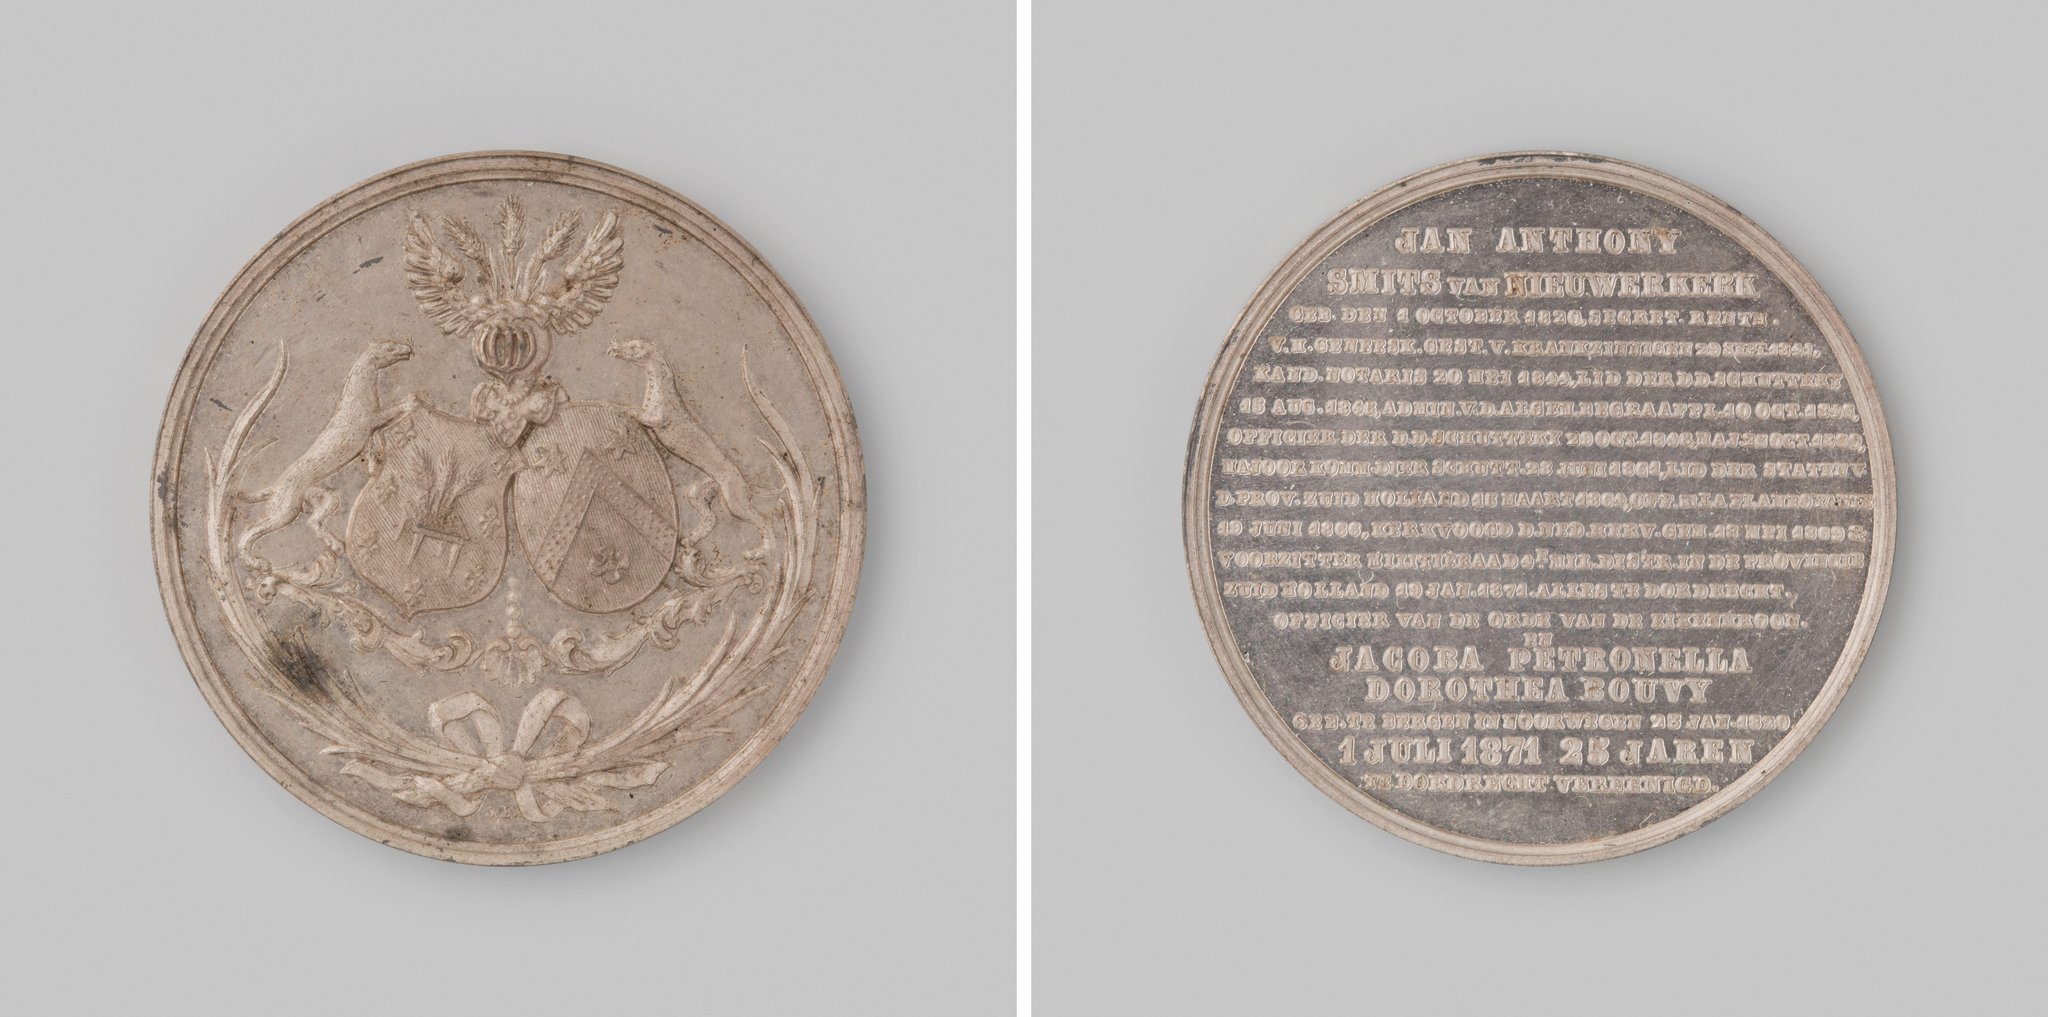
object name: history medal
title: Op de 25jarige echtvereniging van luitenant-kolonel M.-C.J.A. Smits van Nieuwerkerk, oud-commandant der schutterij te Dordrecht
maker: Anonymous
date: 1871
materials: silver